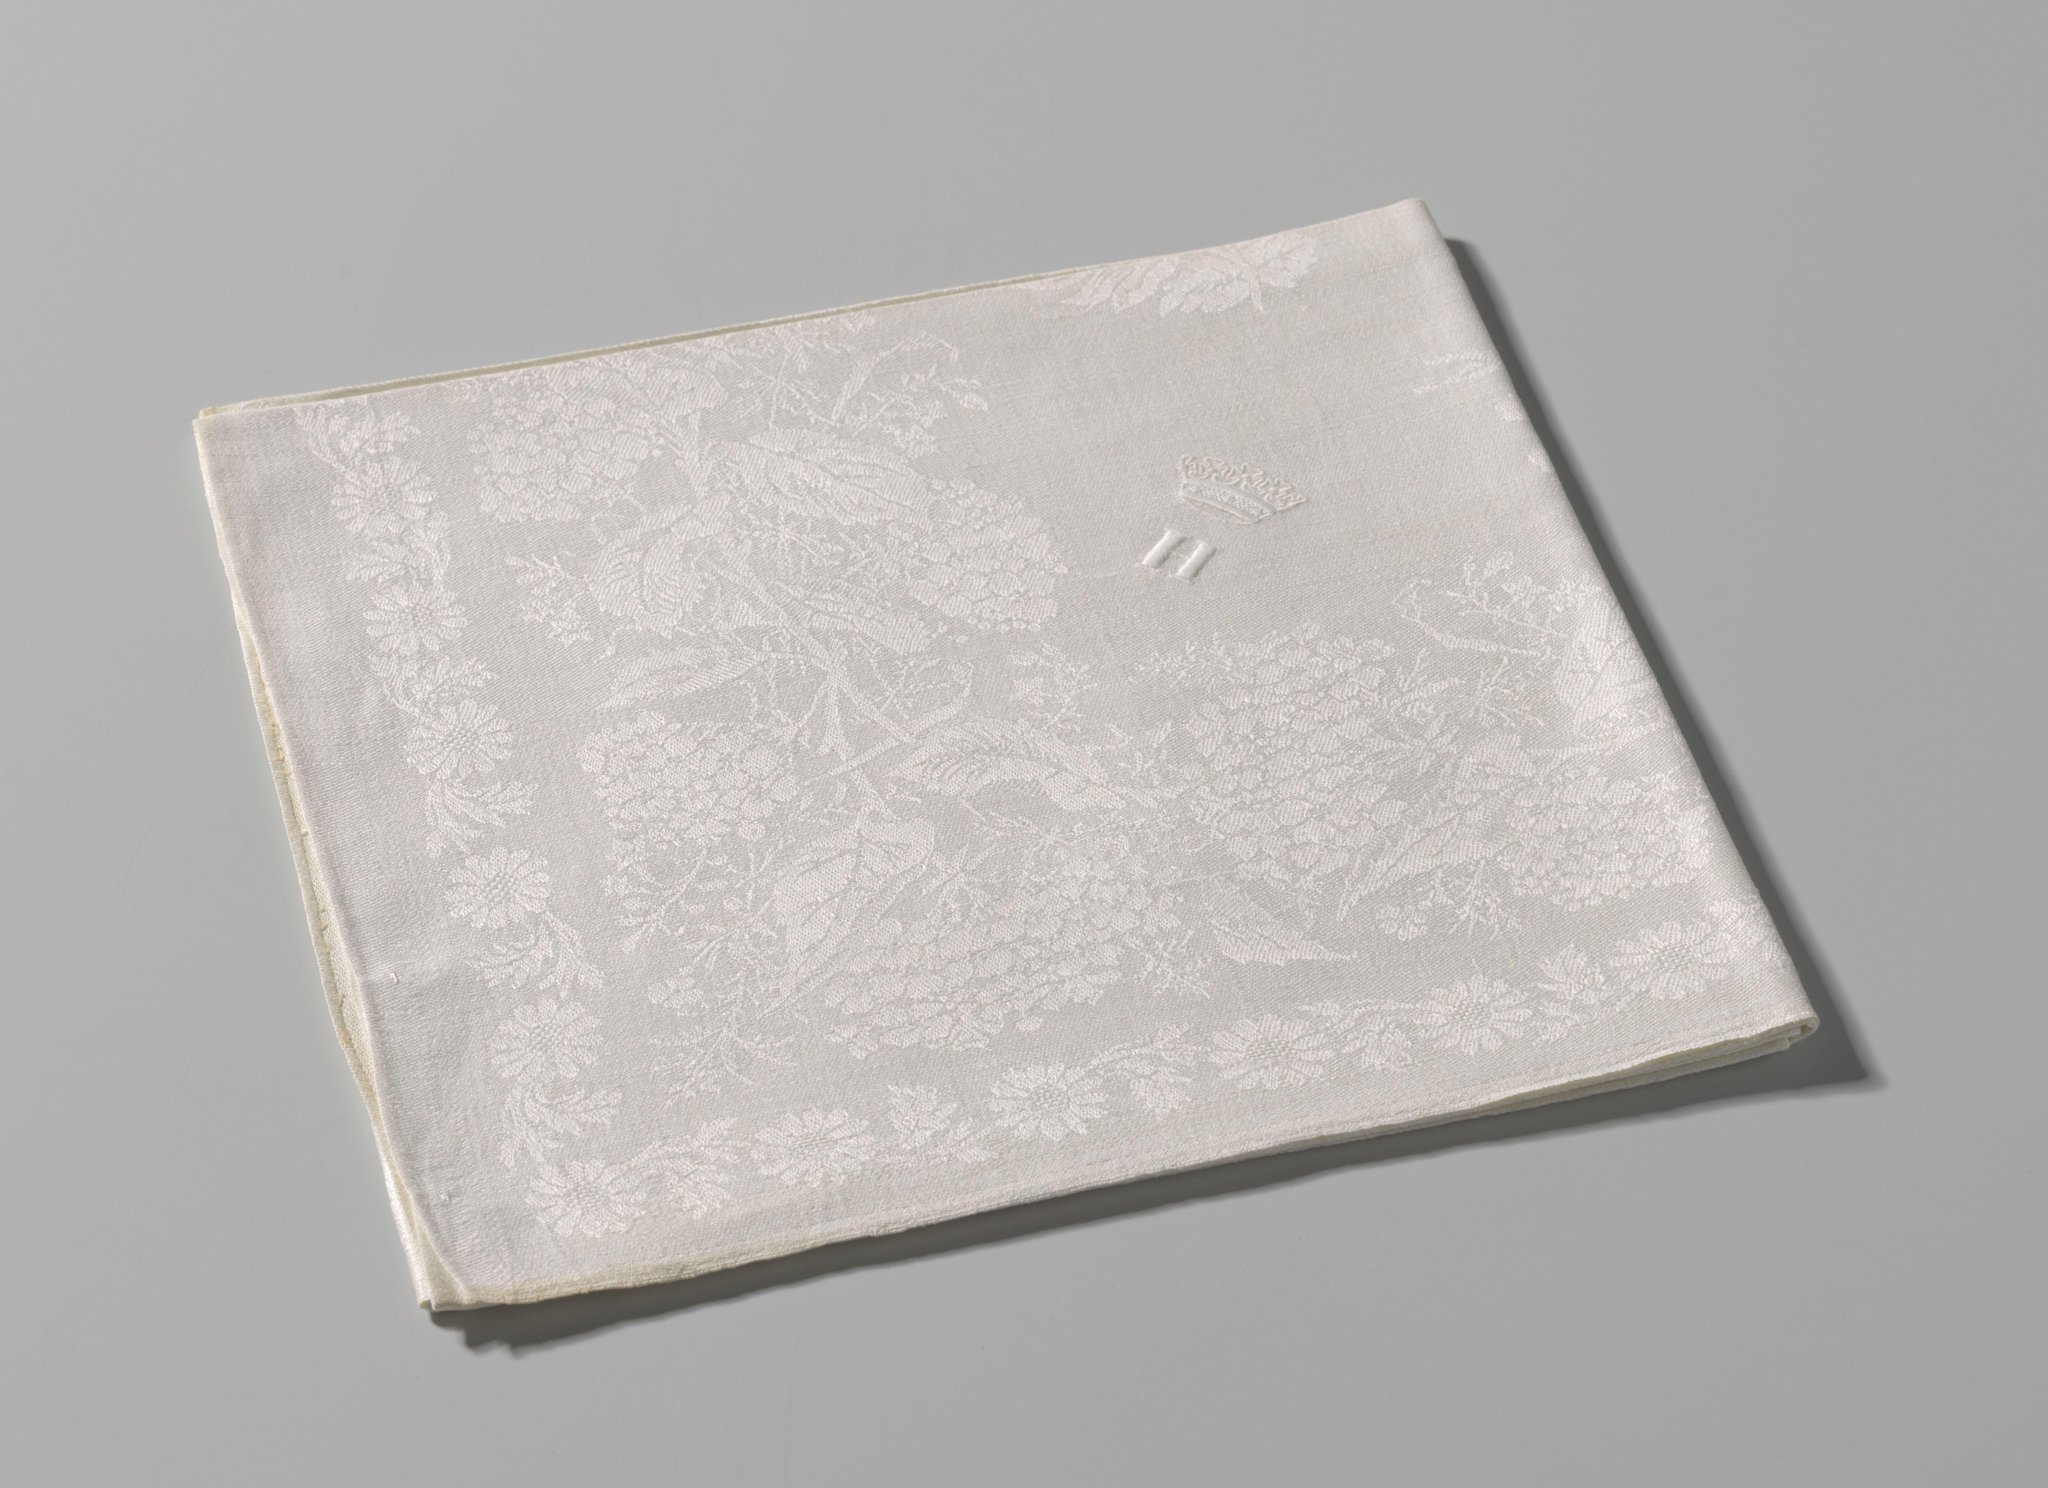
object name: napkin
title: Servet van wit linnendamast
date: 1859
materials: linen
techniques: damask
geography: borne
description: Wit linnen damasten servet met "roos", merk kroon H.